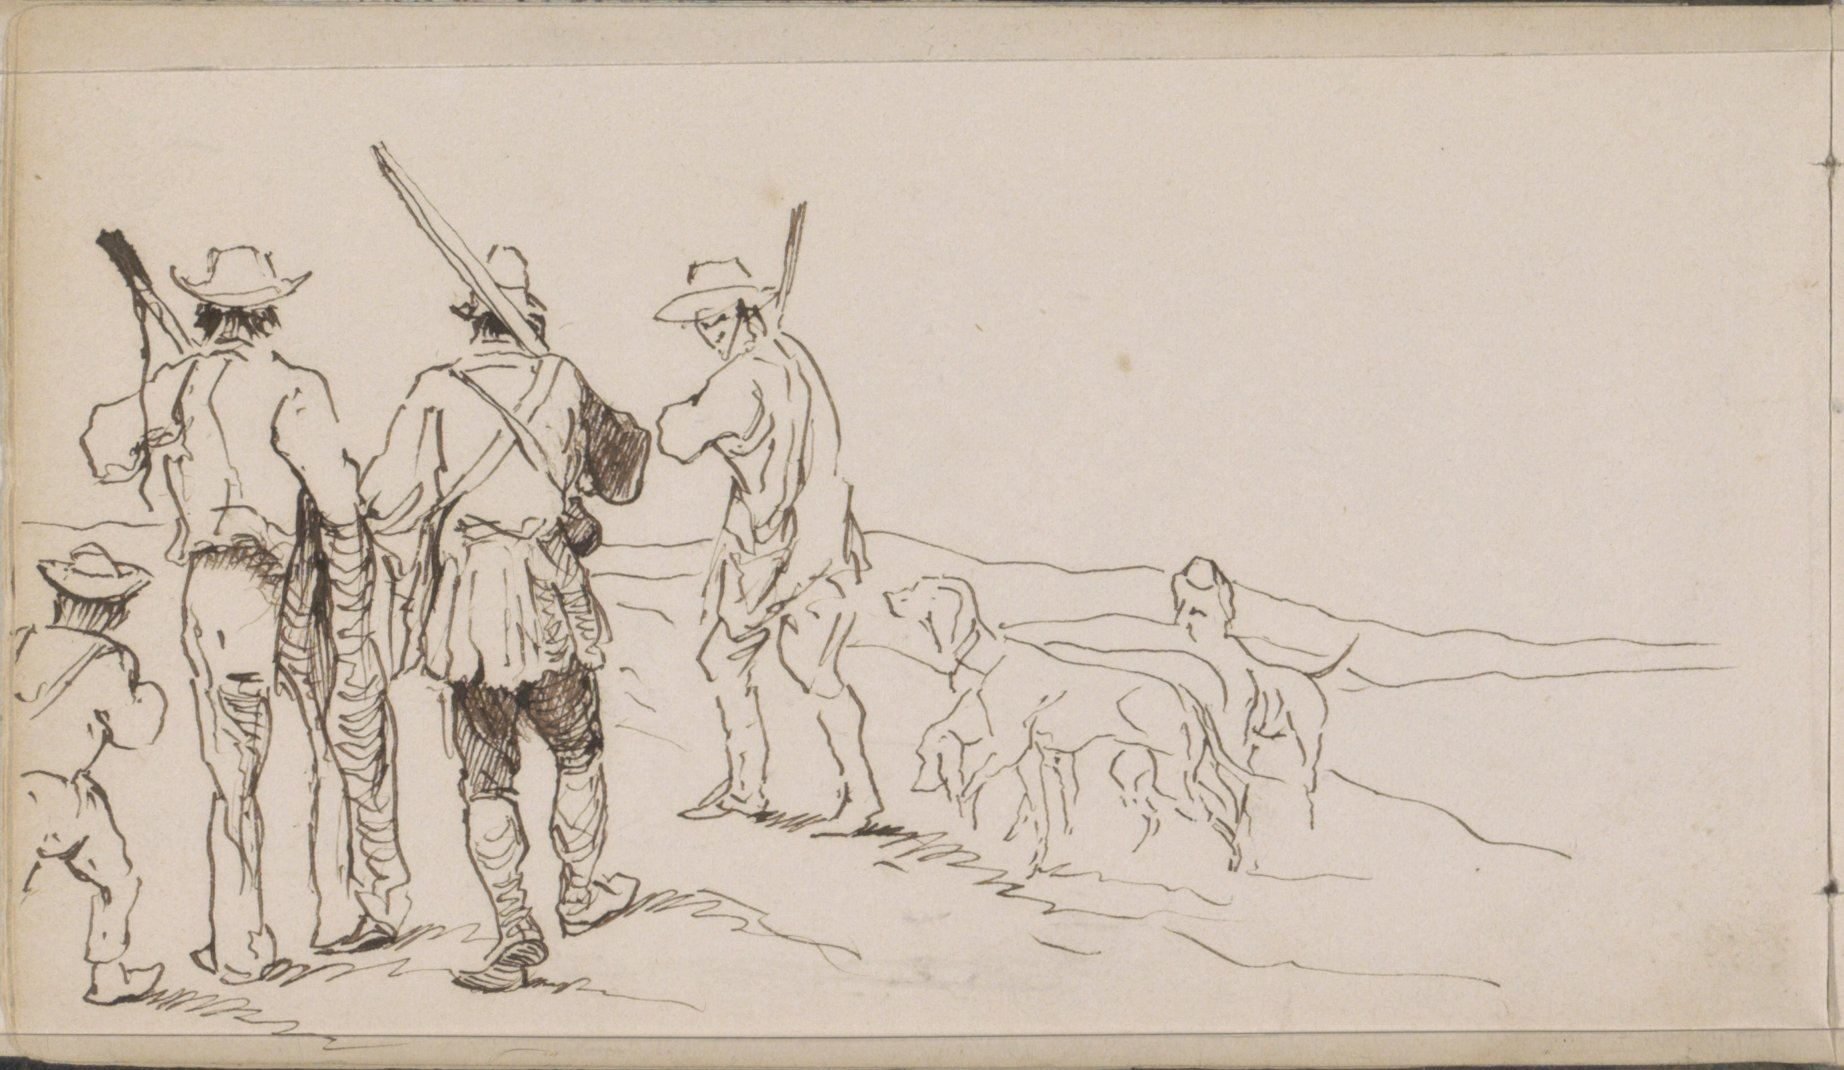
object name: sketchbook leaf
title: Heuvellandschap met jagers en honden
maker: johannes tavenraat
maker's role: draughtsman, painter, print maker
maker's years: 1809-1881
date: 1873-1876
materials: ink, paper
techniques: pen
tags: low hill country, hunter, firearms, dog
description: Blad 3 verso uit een schetsboek met 46 bladen.